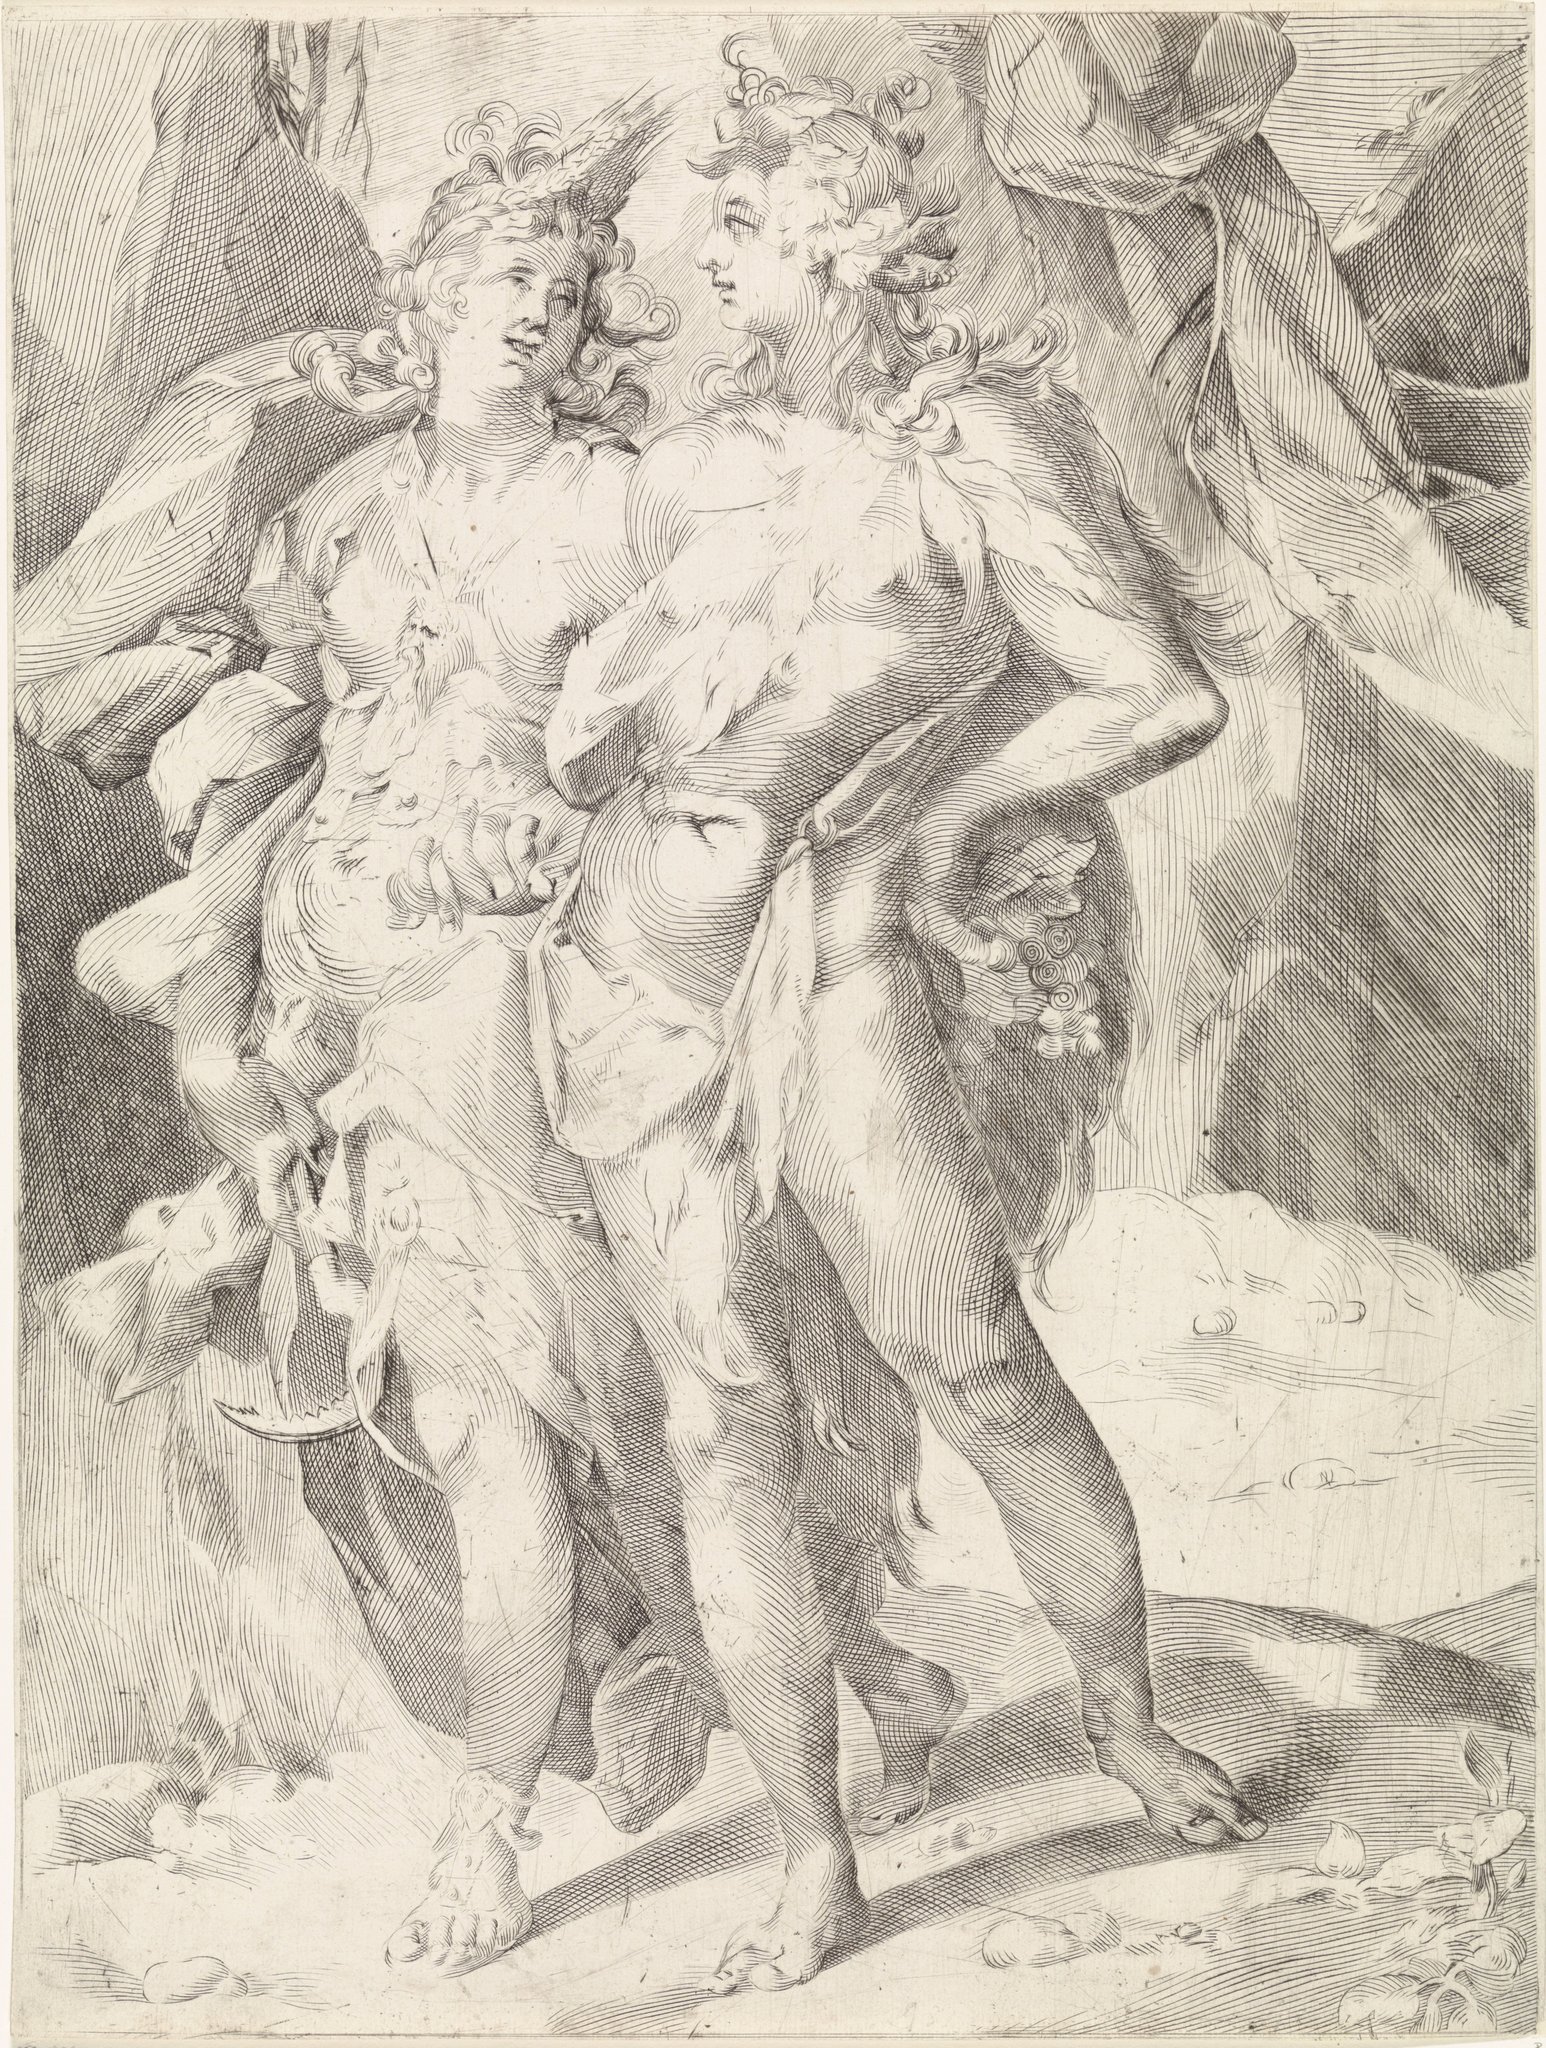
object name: print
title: Ceres en Bacchus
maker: Anonymous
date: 1595-1678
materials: paper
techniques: engraving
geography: netherlands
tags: (story of) ceres (demeter), (story of) bacchus (dionysus), liber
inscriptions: collector's mark: Lugt 240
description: Ceres en Bacchus lopen hand in hand. Ceres houdt een sikkel in de hand en draagt korenaren in haar haren. Bacchus houdt een druiventros in de hand.